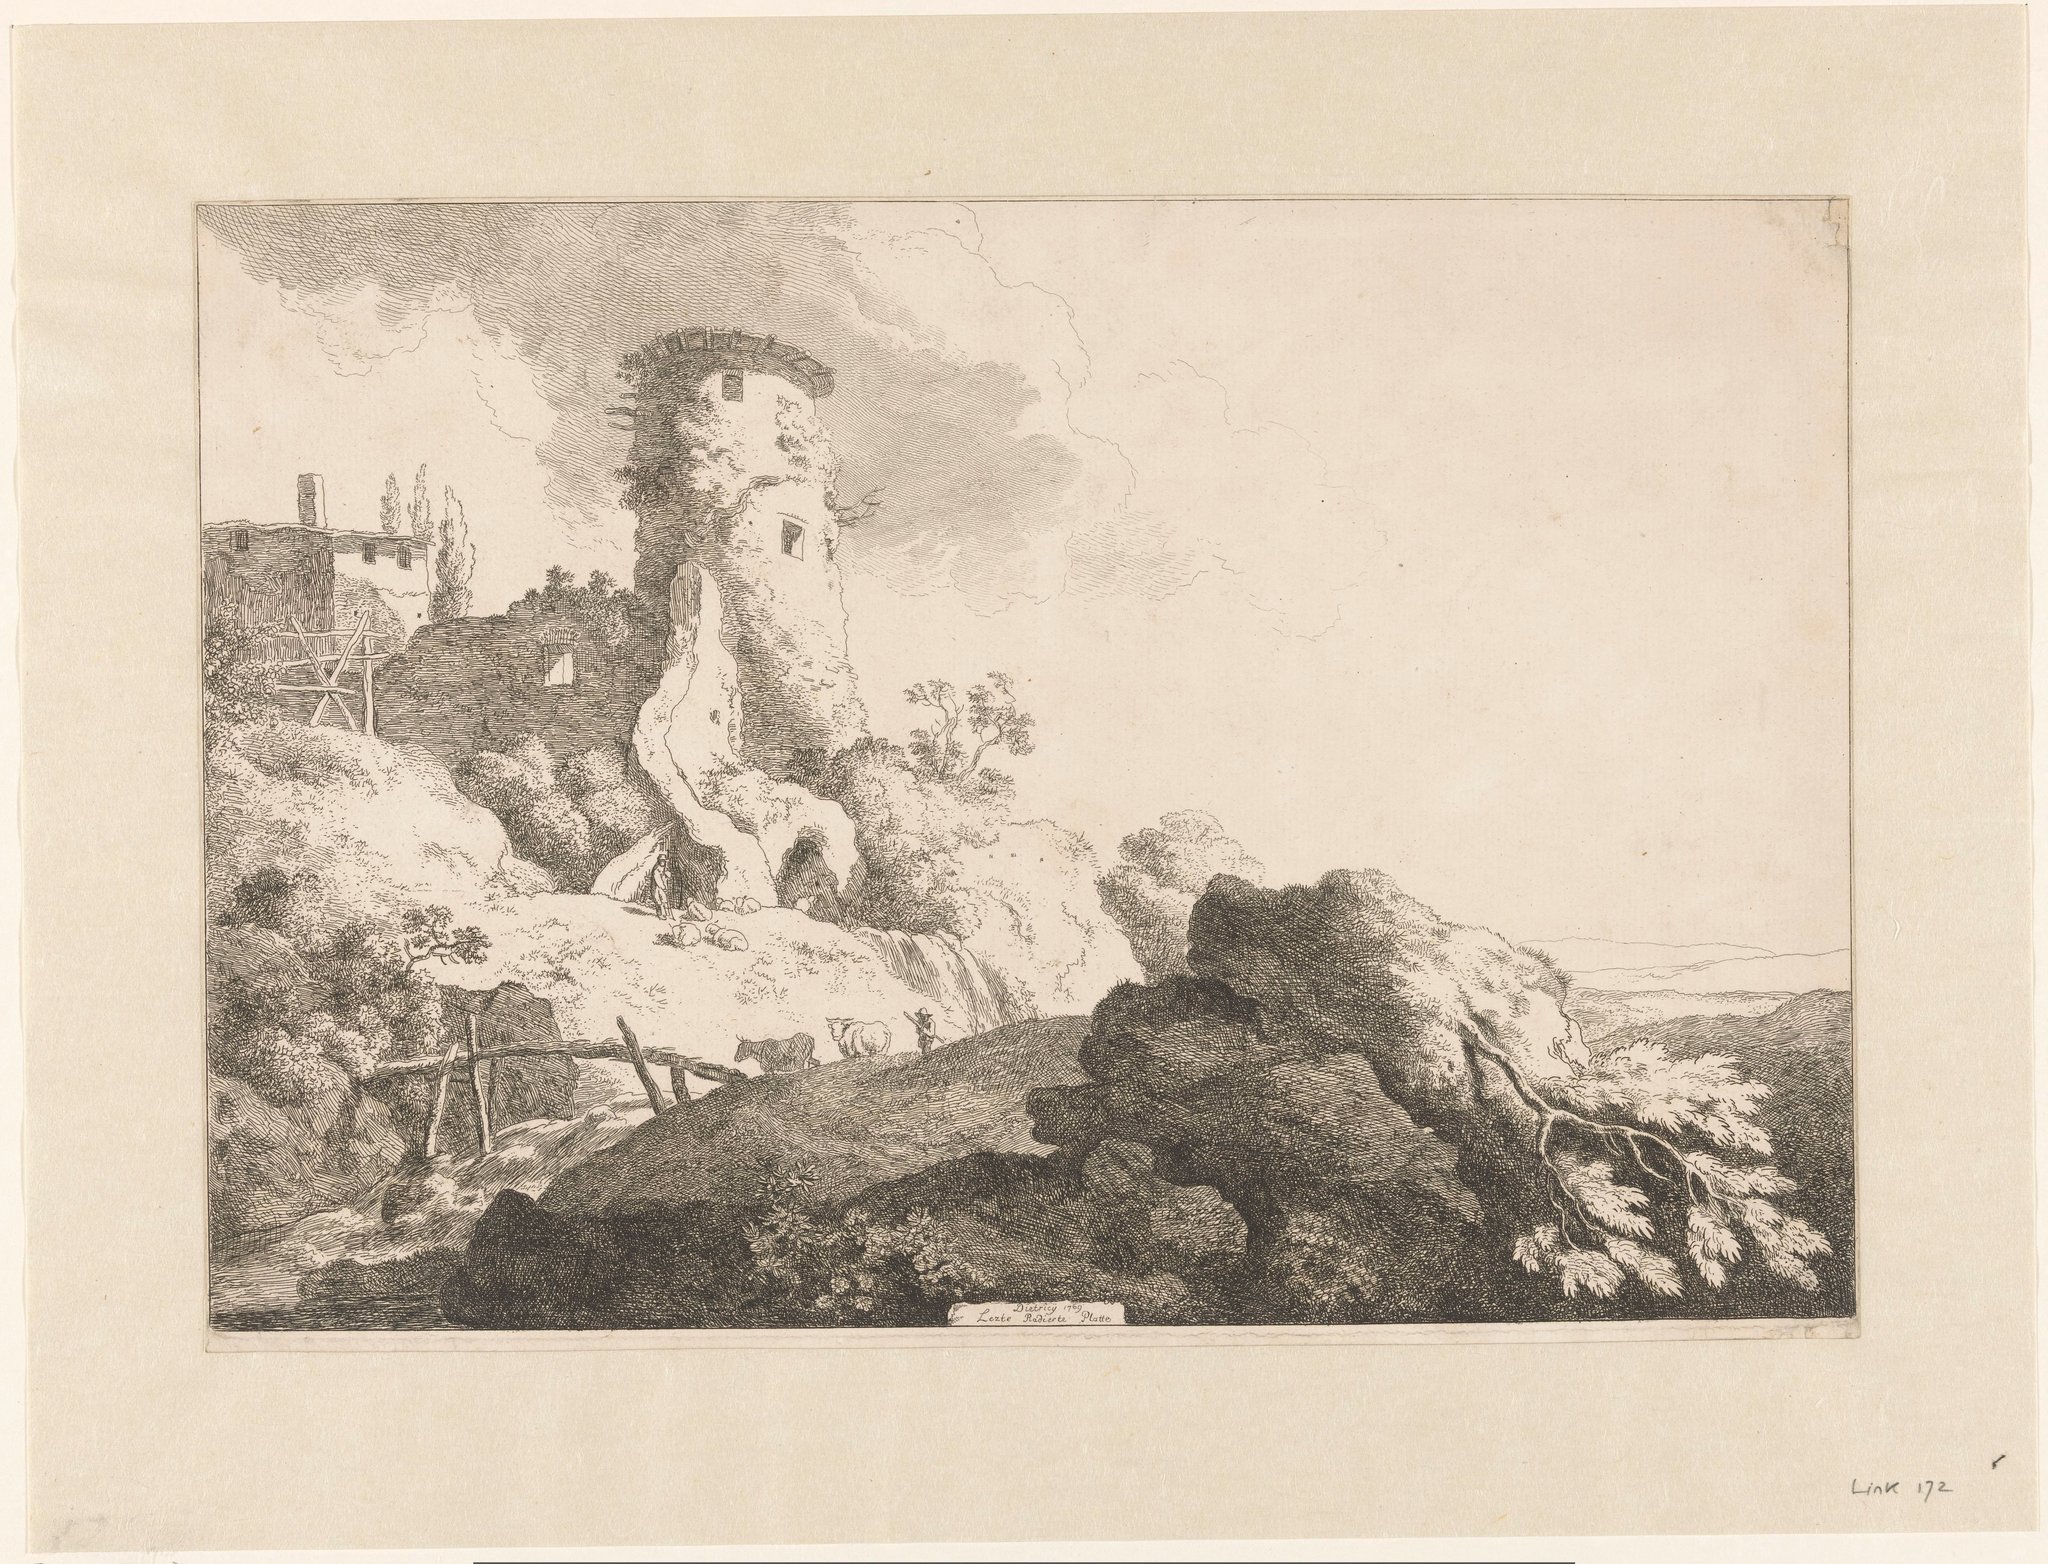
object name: print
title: Heuvellandschap met toren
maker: christian wilhelm ernst dietrich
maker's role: artist, painter, print maker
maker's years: 1712-1774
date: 1769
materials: paper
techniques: etching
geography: dresden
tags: city-view, and landscape with man-made constructions, cow, tower, clock tower ~ monumental adornment, herding, herdsman, herdswoman, shepherd, shepherdess, cowherd, etc., sheep, bridge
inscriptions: collector's mark: Lugt 2760, collector's mark: Lugt 2228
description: In de kleine uitsparing onderaan de prent staat vermeld dat dit de laatste prent is die Dietrich etste voor zijn dood in 1774.